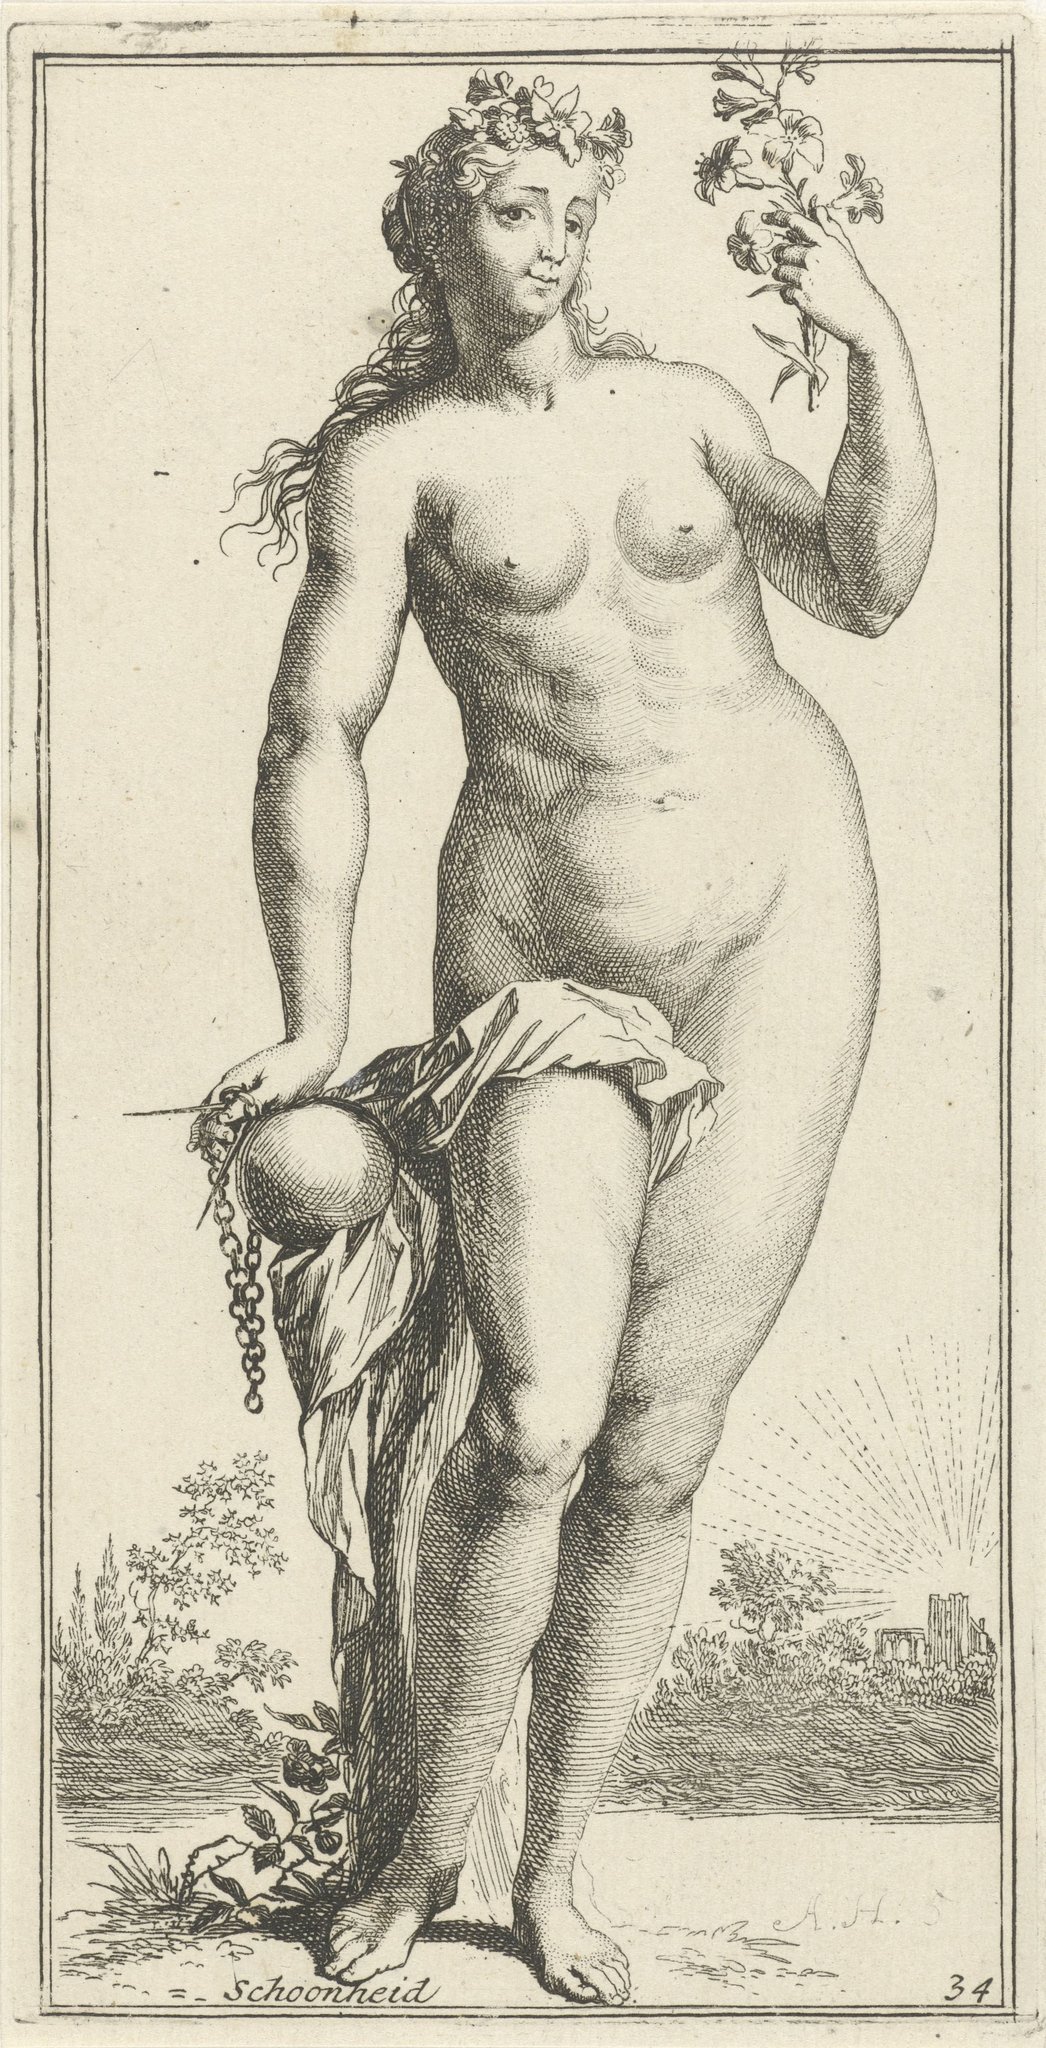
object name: print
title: Personificatie van schoonheid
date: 1710-1719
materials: paper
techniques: engraving, etching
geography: amsterdam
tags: circle symbolizing god's perfectness, measuring-instruments, sunbeams, flowers: lily, beauty; 'bellezza' (ripa) (+ nude)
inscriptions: collector's mark: Lugt 2228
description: Een naakte vrouwfiguur als personificatie van schoonheid, met in haar rechterhand een bol aan een ketting en een passer en in haar linkerhand een lelietak. Op de achtergrond een stralenkrans. Prent uit een serie van 41 zinnebeelden.